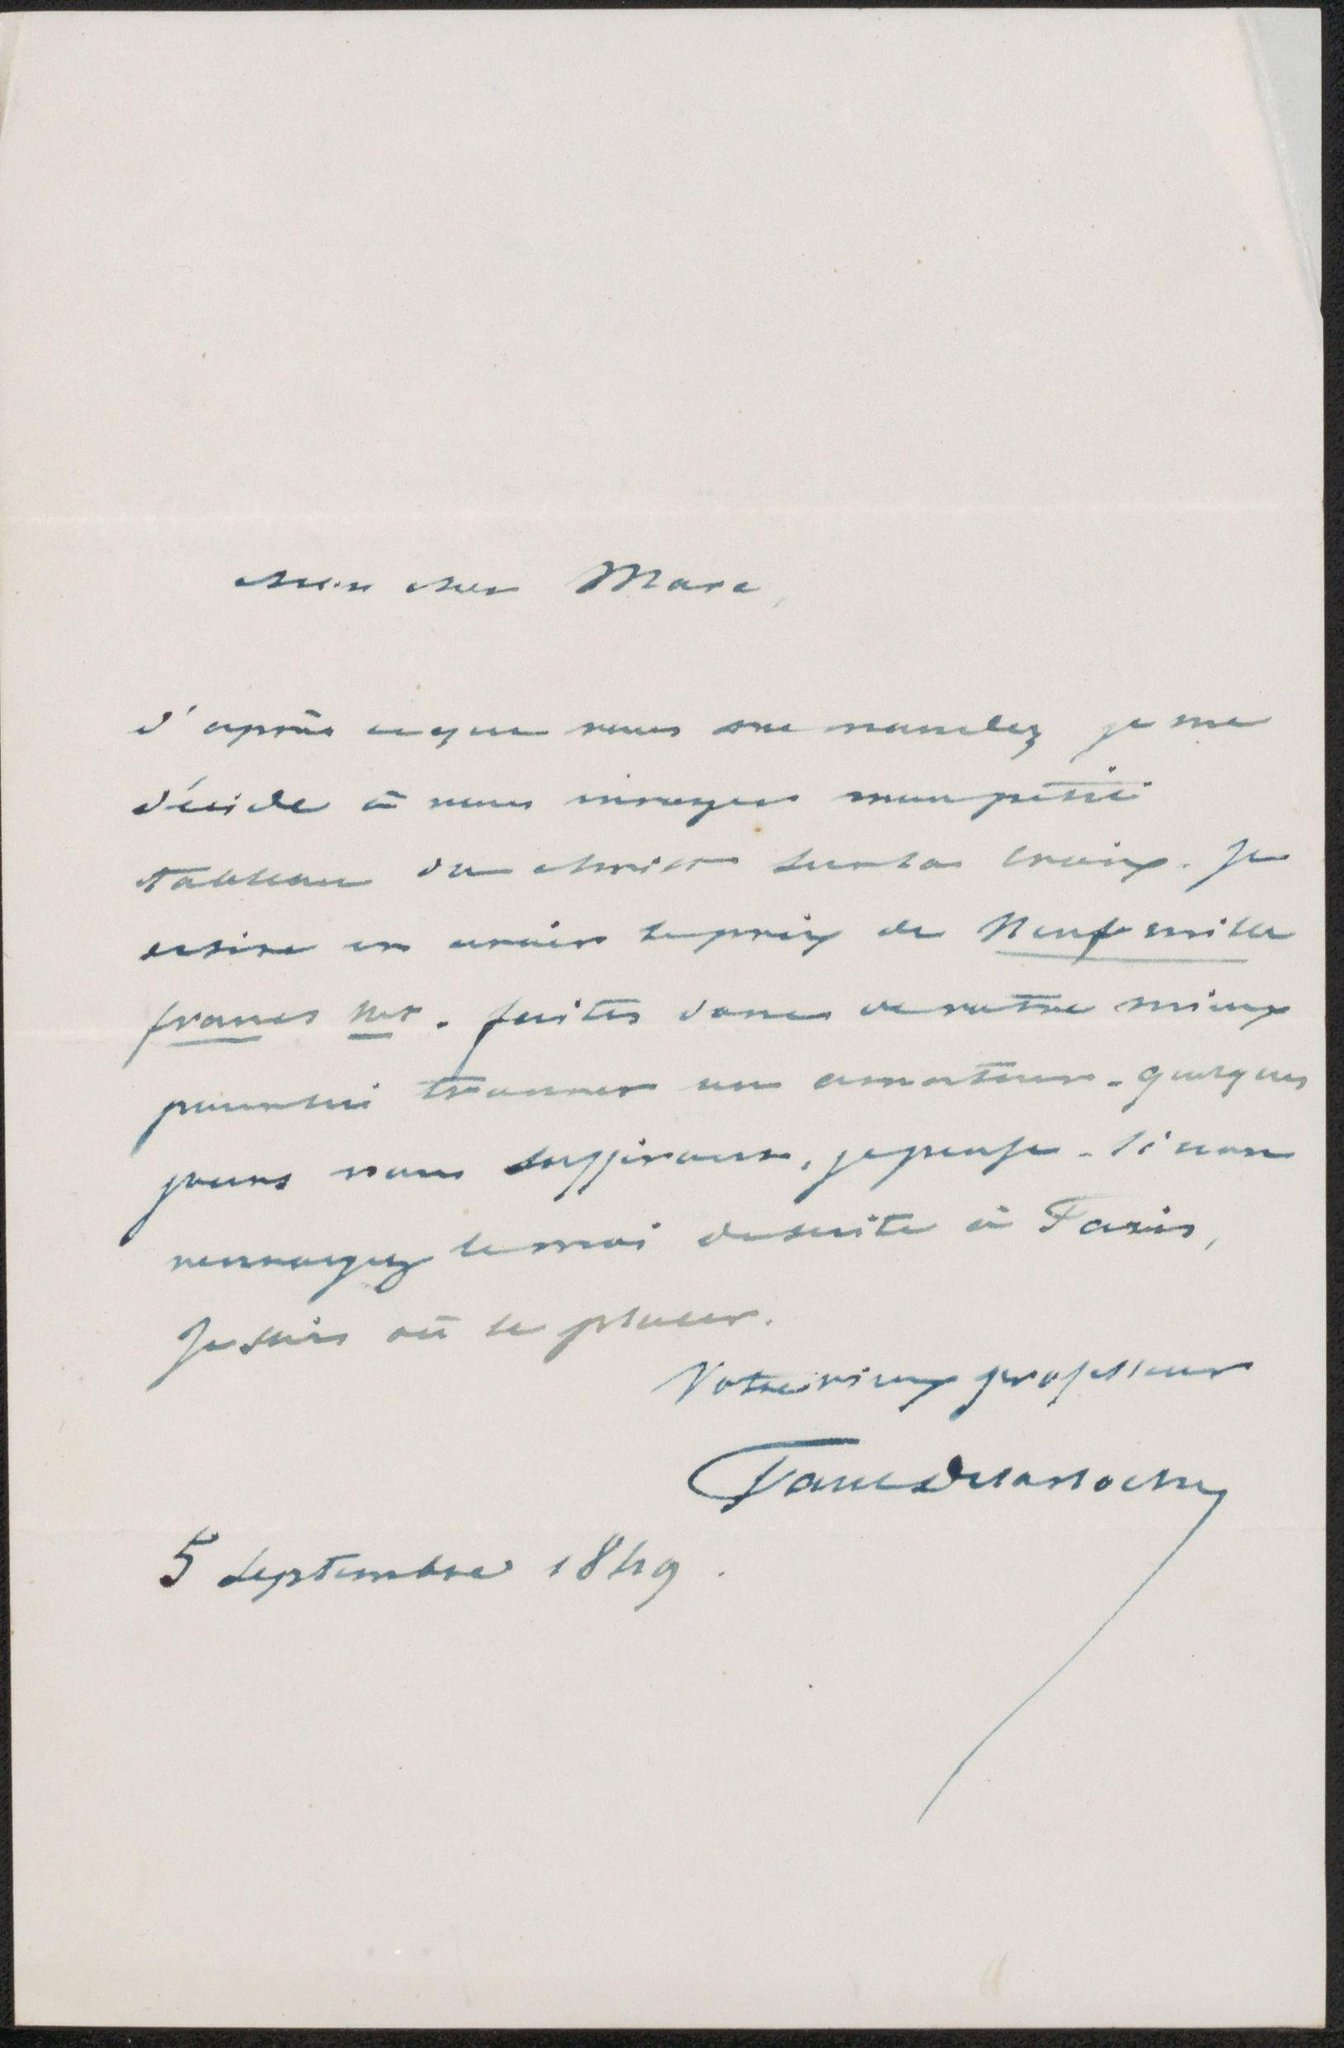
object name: letter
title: Brief aan Ary Johannes Lamme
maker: paul delaroche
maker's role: draughtsman, painter, sculptor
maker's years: 1797-1856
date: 1849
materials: ink, paper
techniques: pen, writing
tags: dordrecht, print maker, draughtsman, ary johannes lamme, art trade, art shop, painting (including book-illumination, miniature-painting), paris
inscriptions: collector's mark: Lugt 2228